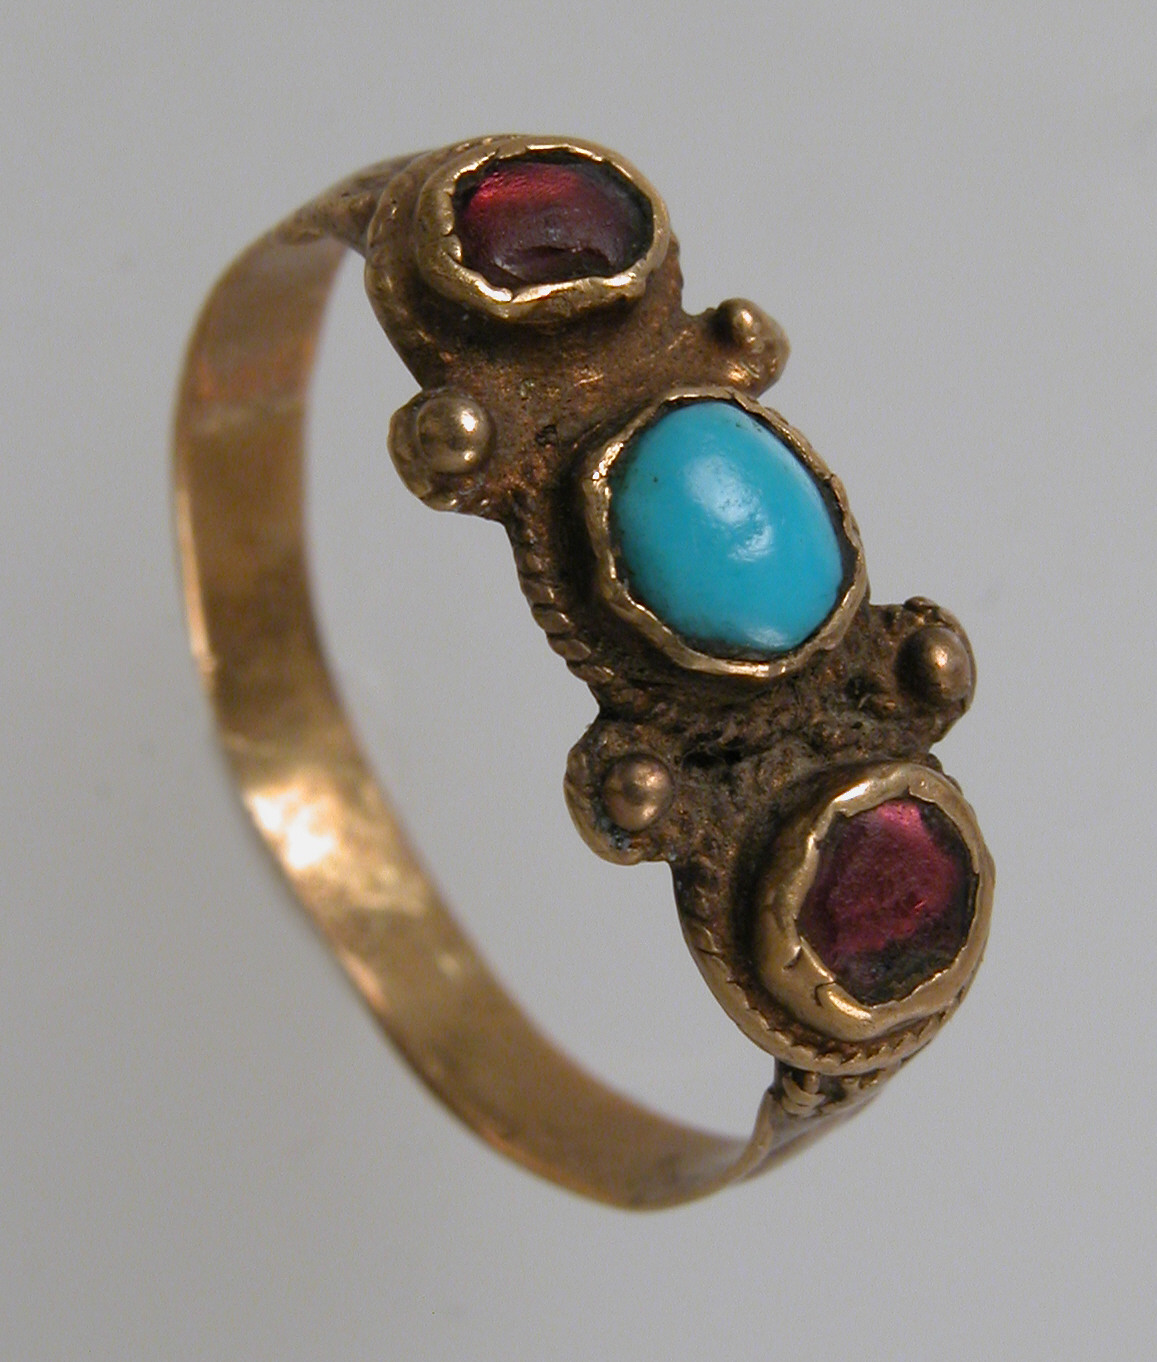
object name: ring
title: Finger Ring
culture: frankish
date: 601-700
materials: glass, gold, paste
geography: northern france